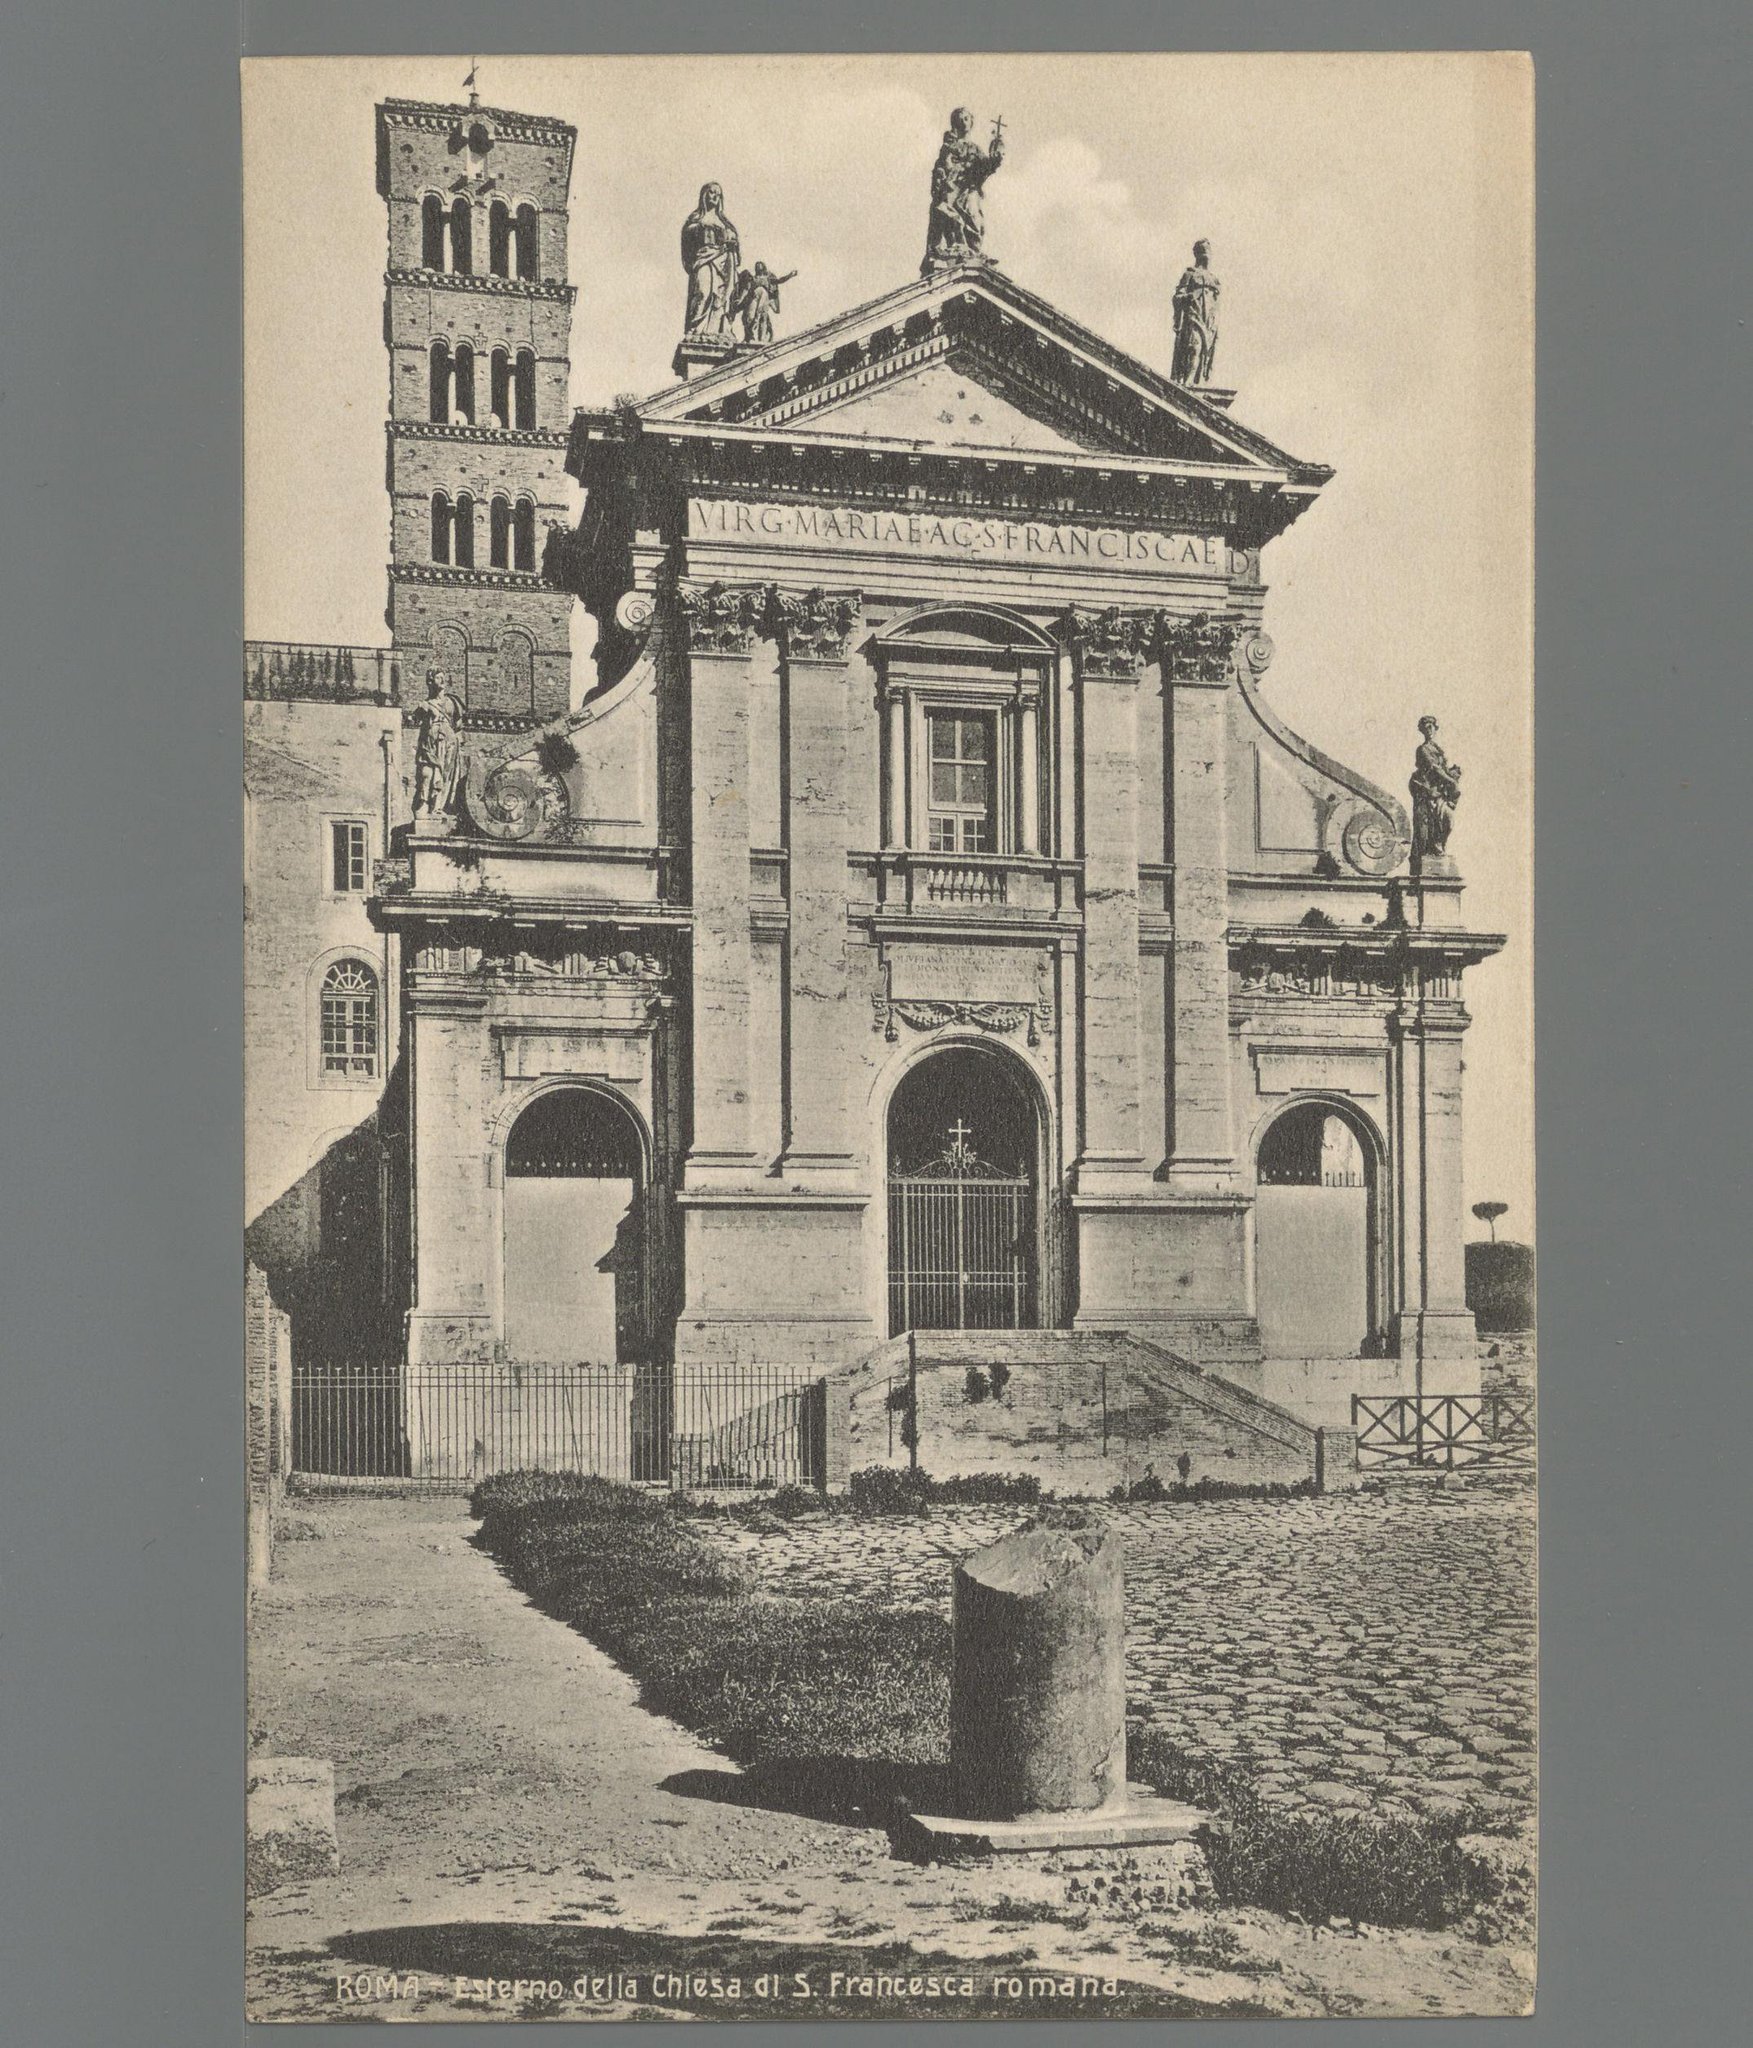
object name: ansichtkaart, prentbriefkaart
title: Roma. Esterno della Chiesa di S. Francesca romana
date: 1906-1920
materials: cardboard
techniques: photograph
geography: rome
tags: church (exterior)